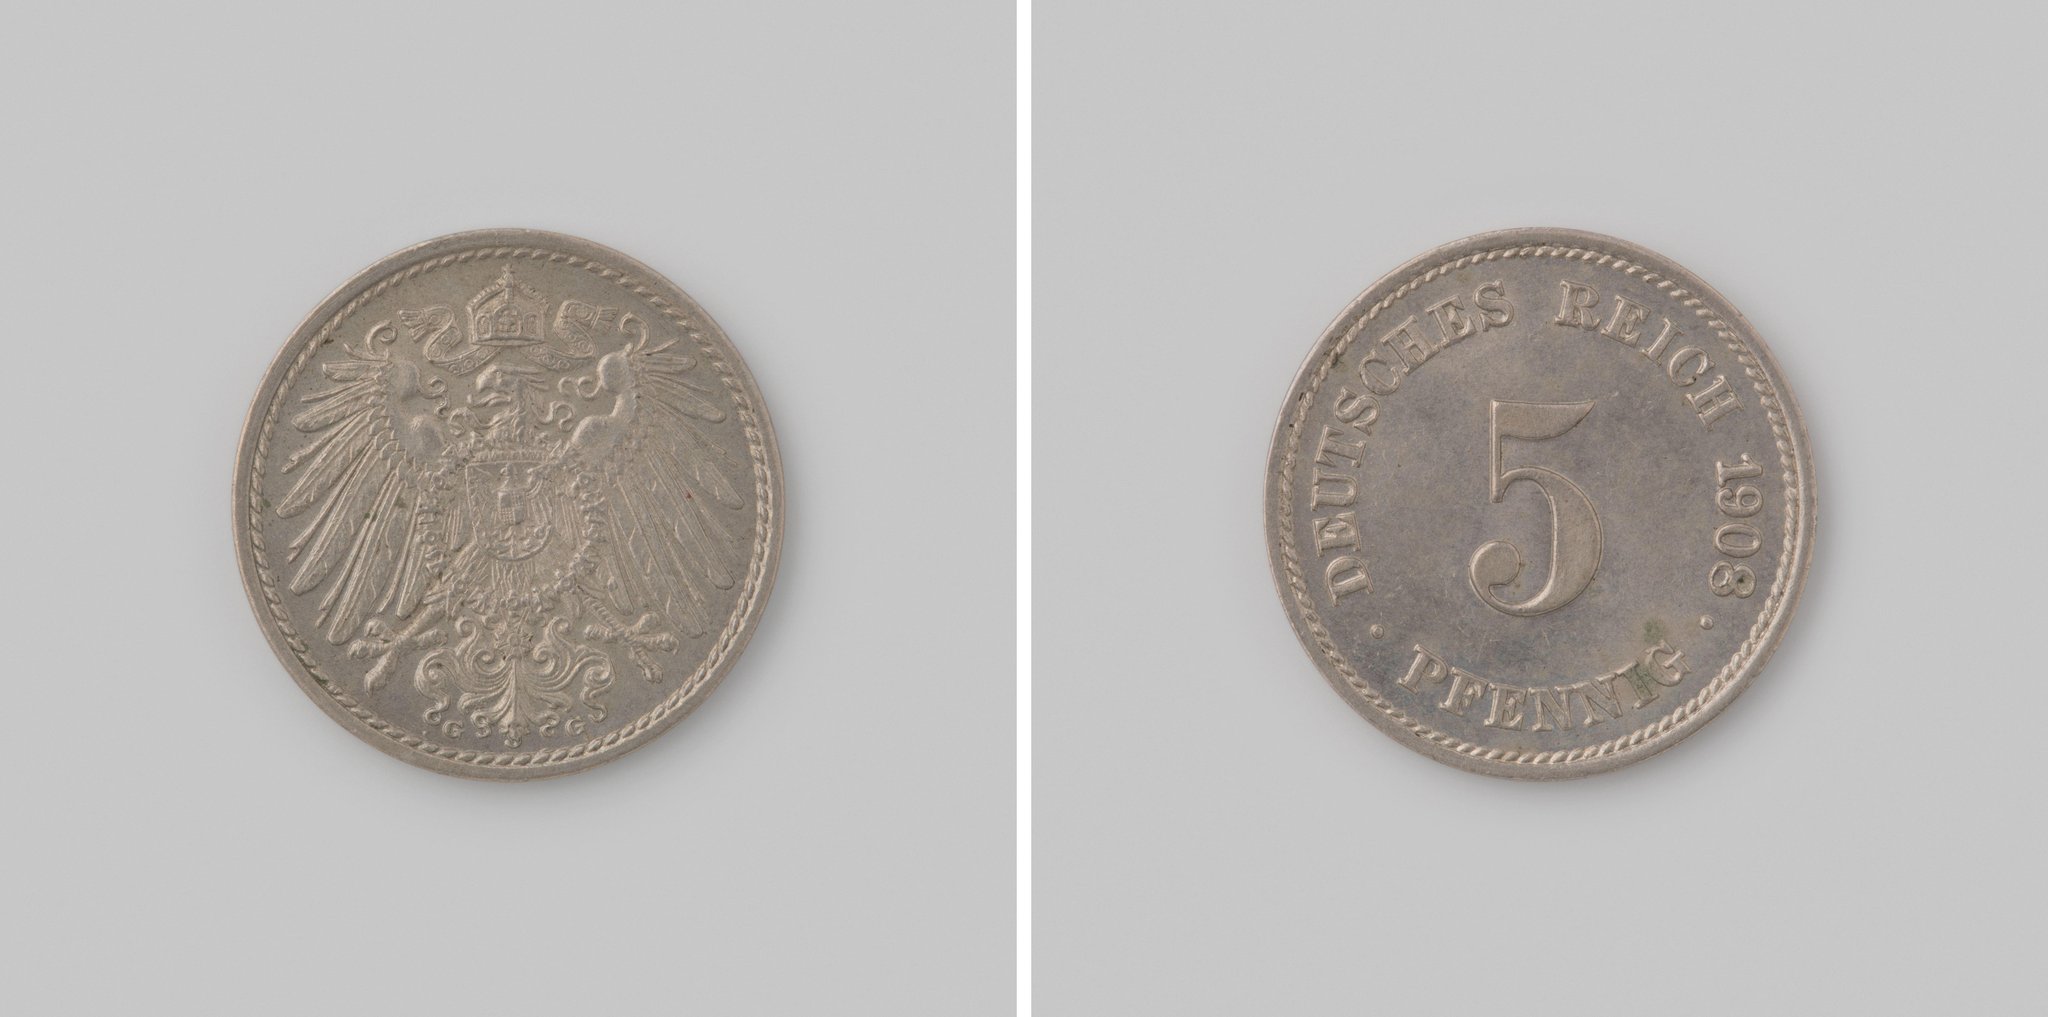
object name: vijf pfennig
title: 5 Pfennig uit het Duitse Rijk, 1908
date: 1908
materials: nickel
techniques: striking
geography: karlsruhe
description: Nikkelen munt. Voorzijde: gekroonde enkelkoppige adelaar naar links met op borst door keten van orde met juweel omhangen samengesteld wapenschild. Daaronder twee letters G. Keerzijde: waarde-aanduiding in twee regels. Jaartal in omschrift. Gladde rand.